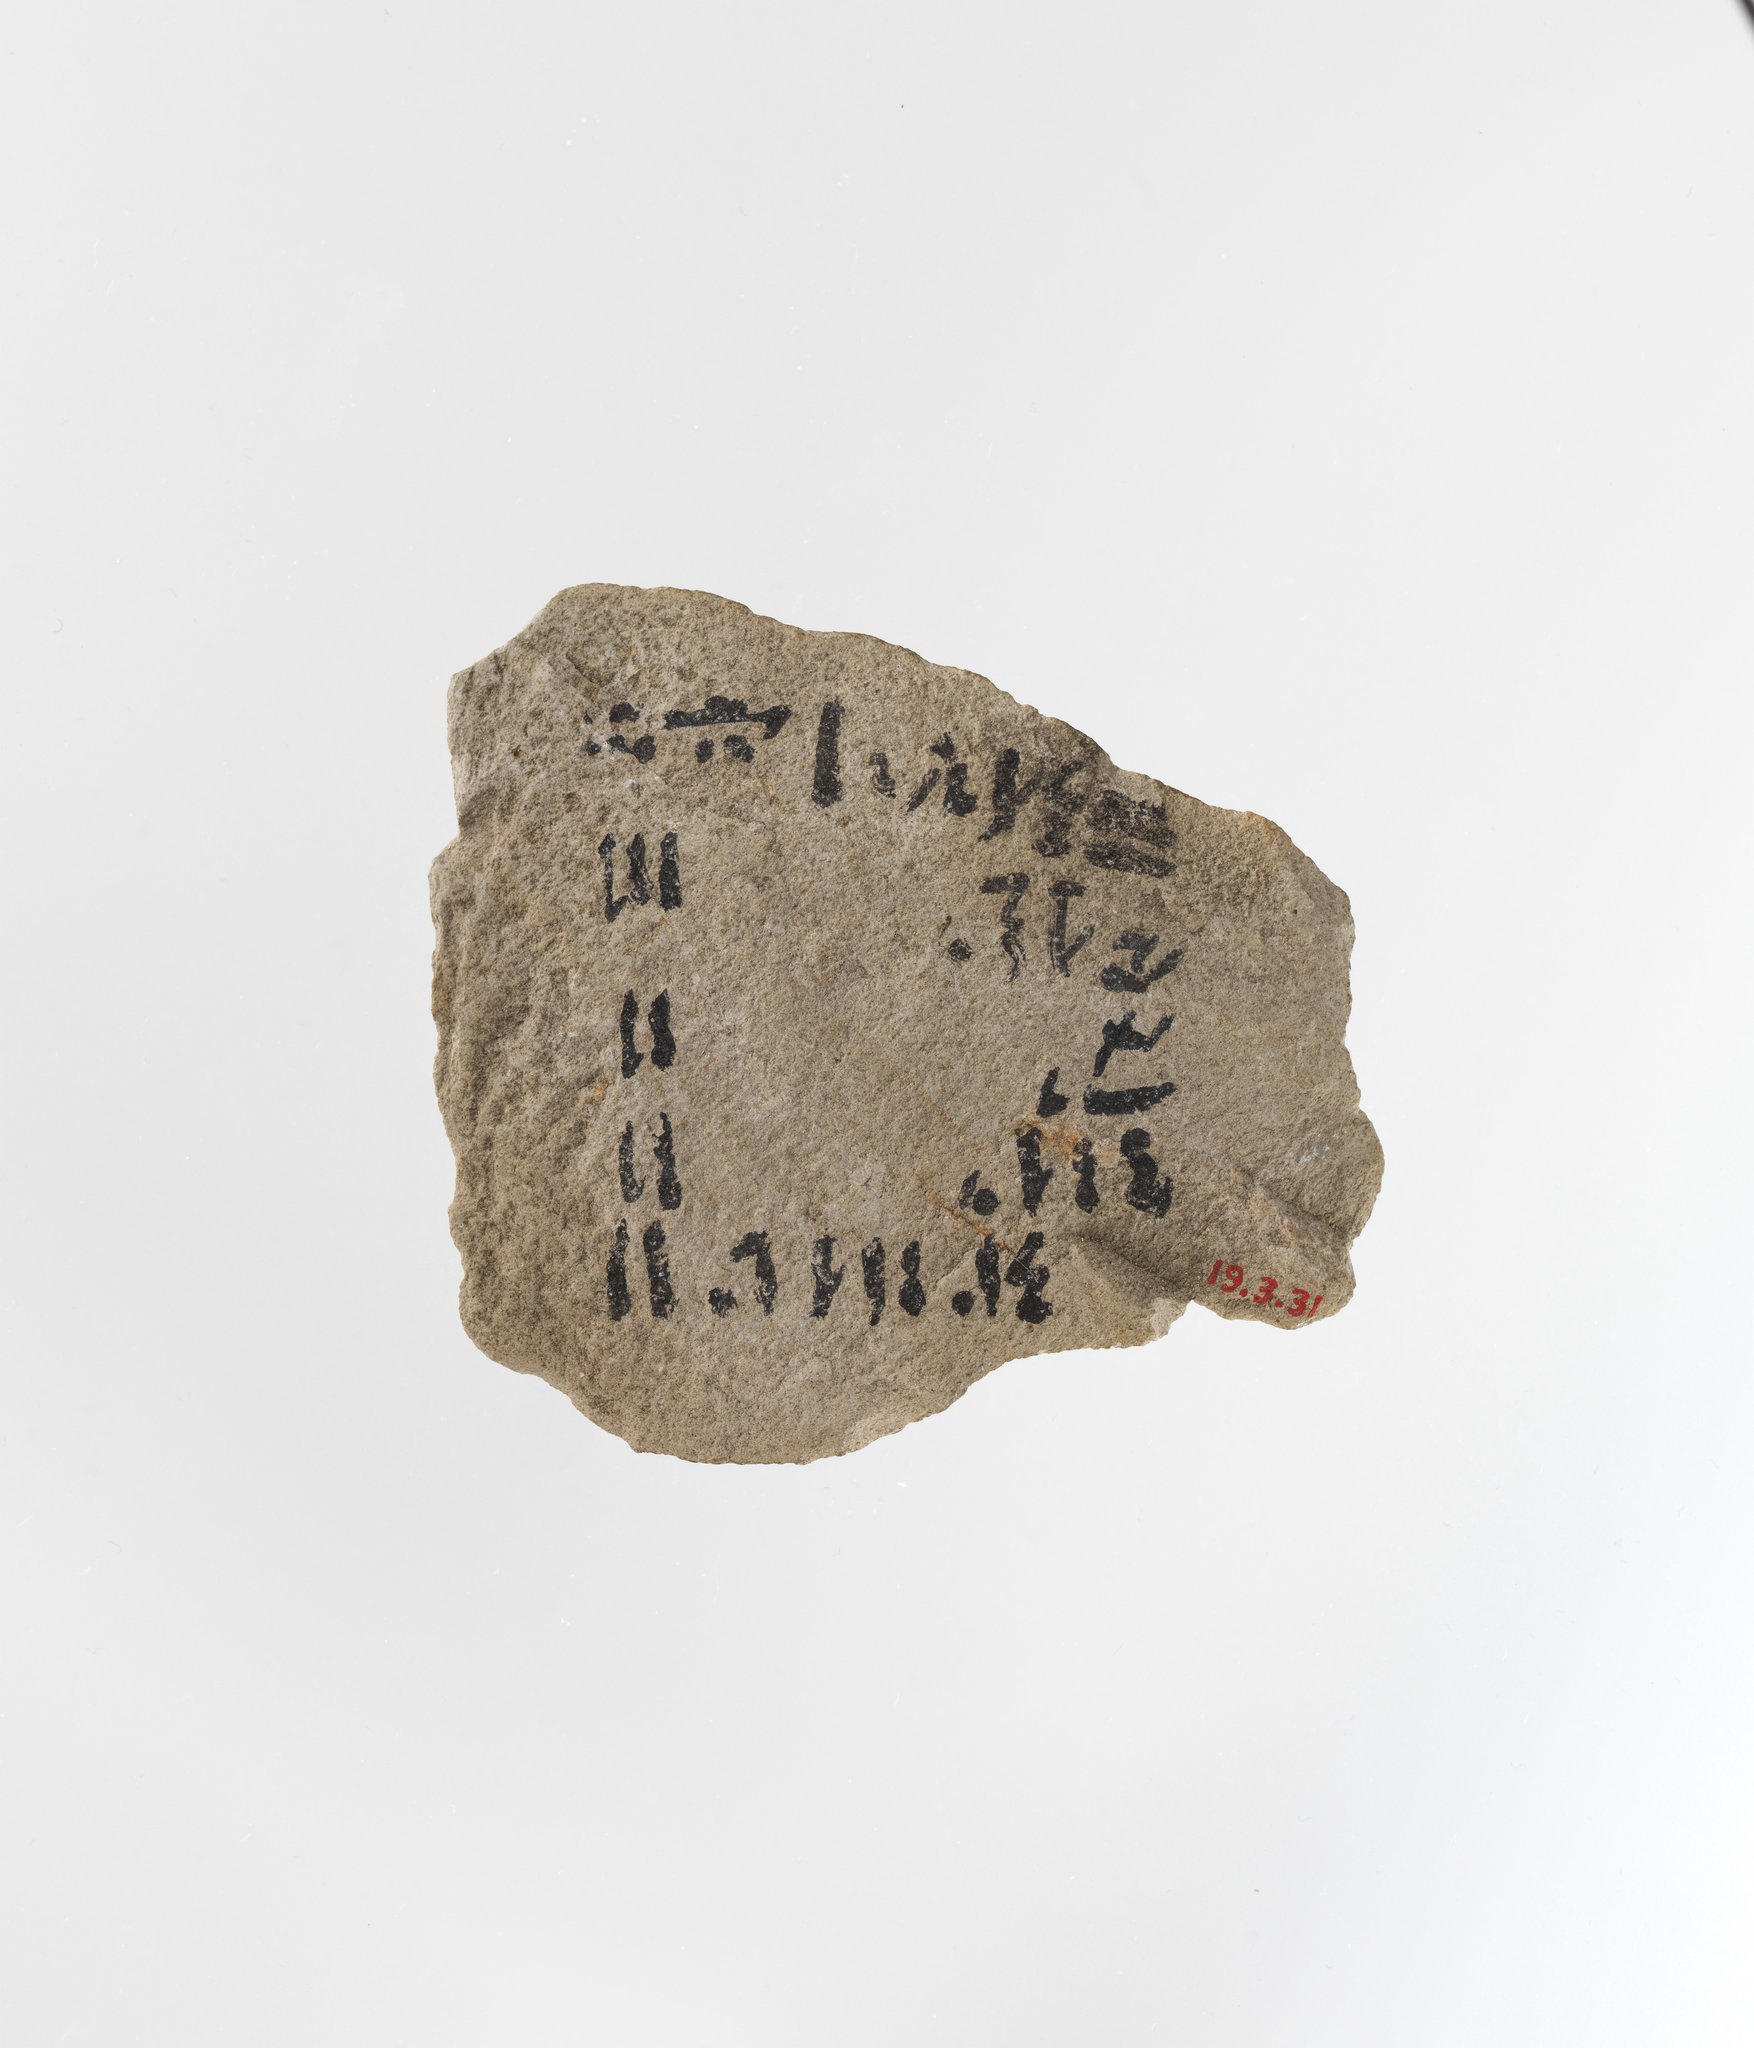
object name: ostracon, hieratic, account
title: Ostracon with hieratic inscription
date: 1295-525 BCE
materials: ink, limestone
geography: egypt